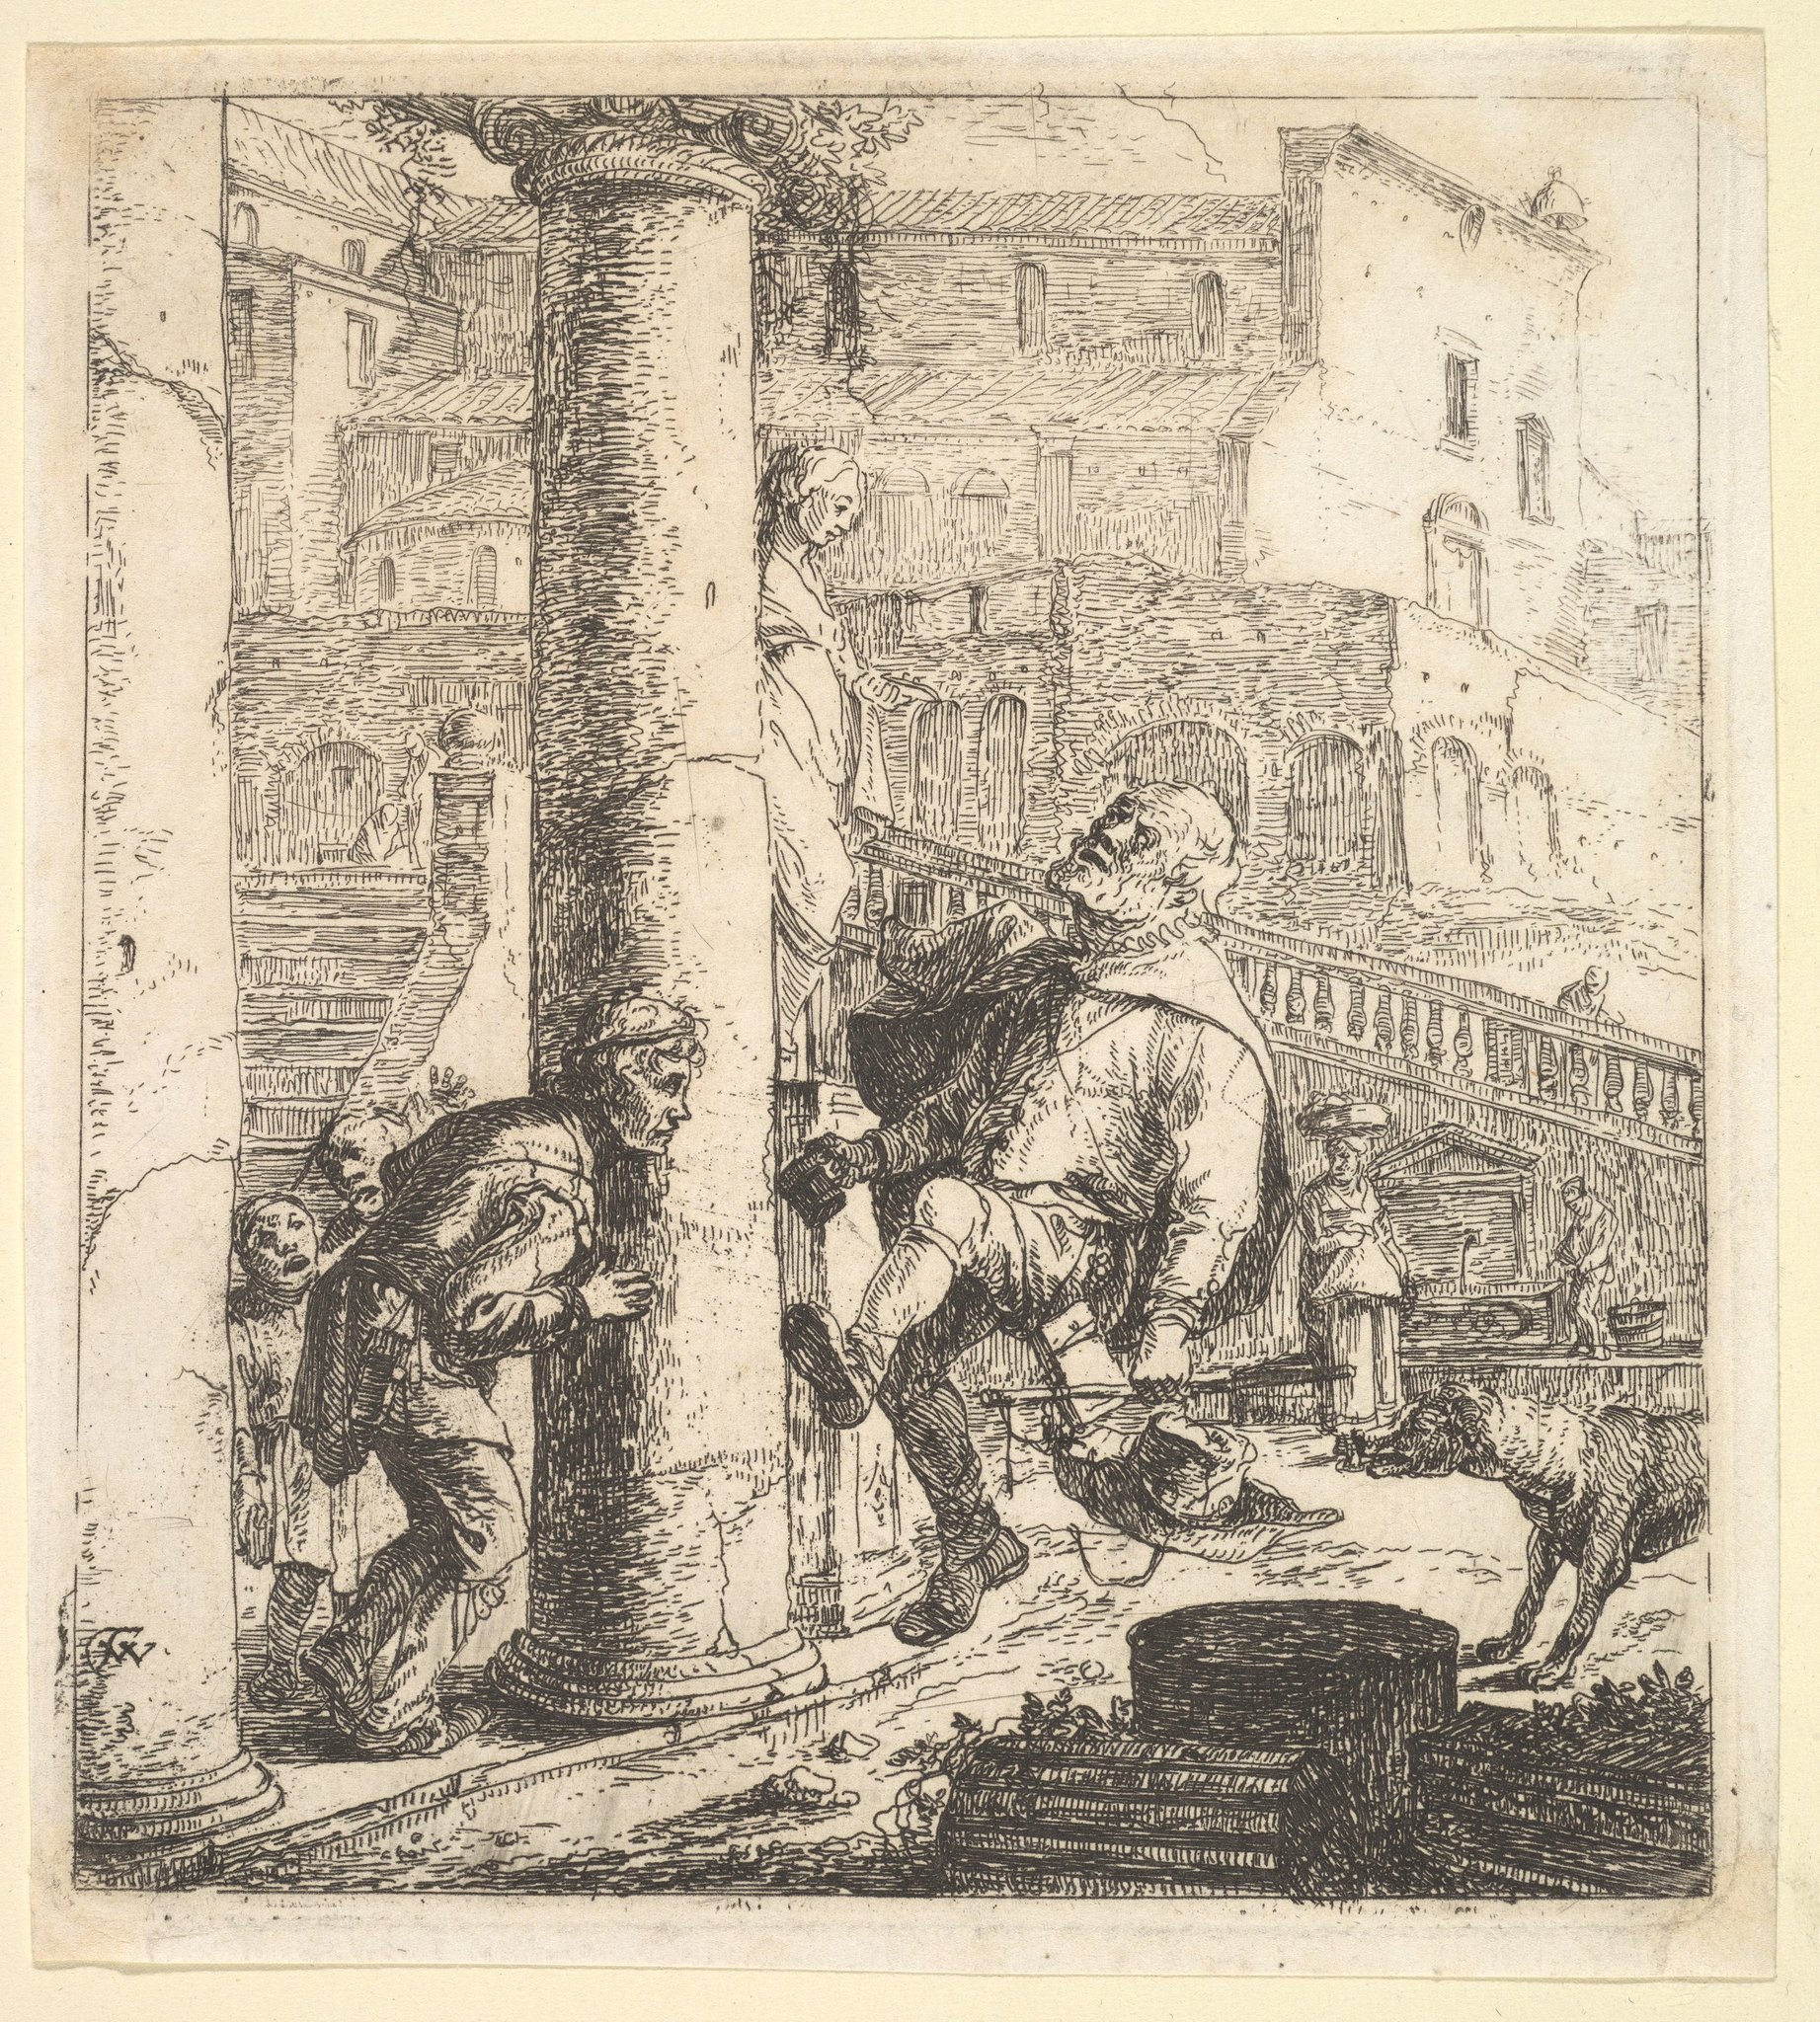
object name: print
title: Blind Beggar Bumping A Pillar; this and 63.616.39 (2) are two plates of beggars from the story of Lazaville de Tormes.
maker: thomas wijck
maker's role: artist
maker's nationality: dutch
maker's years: 1616-1677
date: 1601-1700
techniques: drypoint, etching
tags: columns,men,dogs